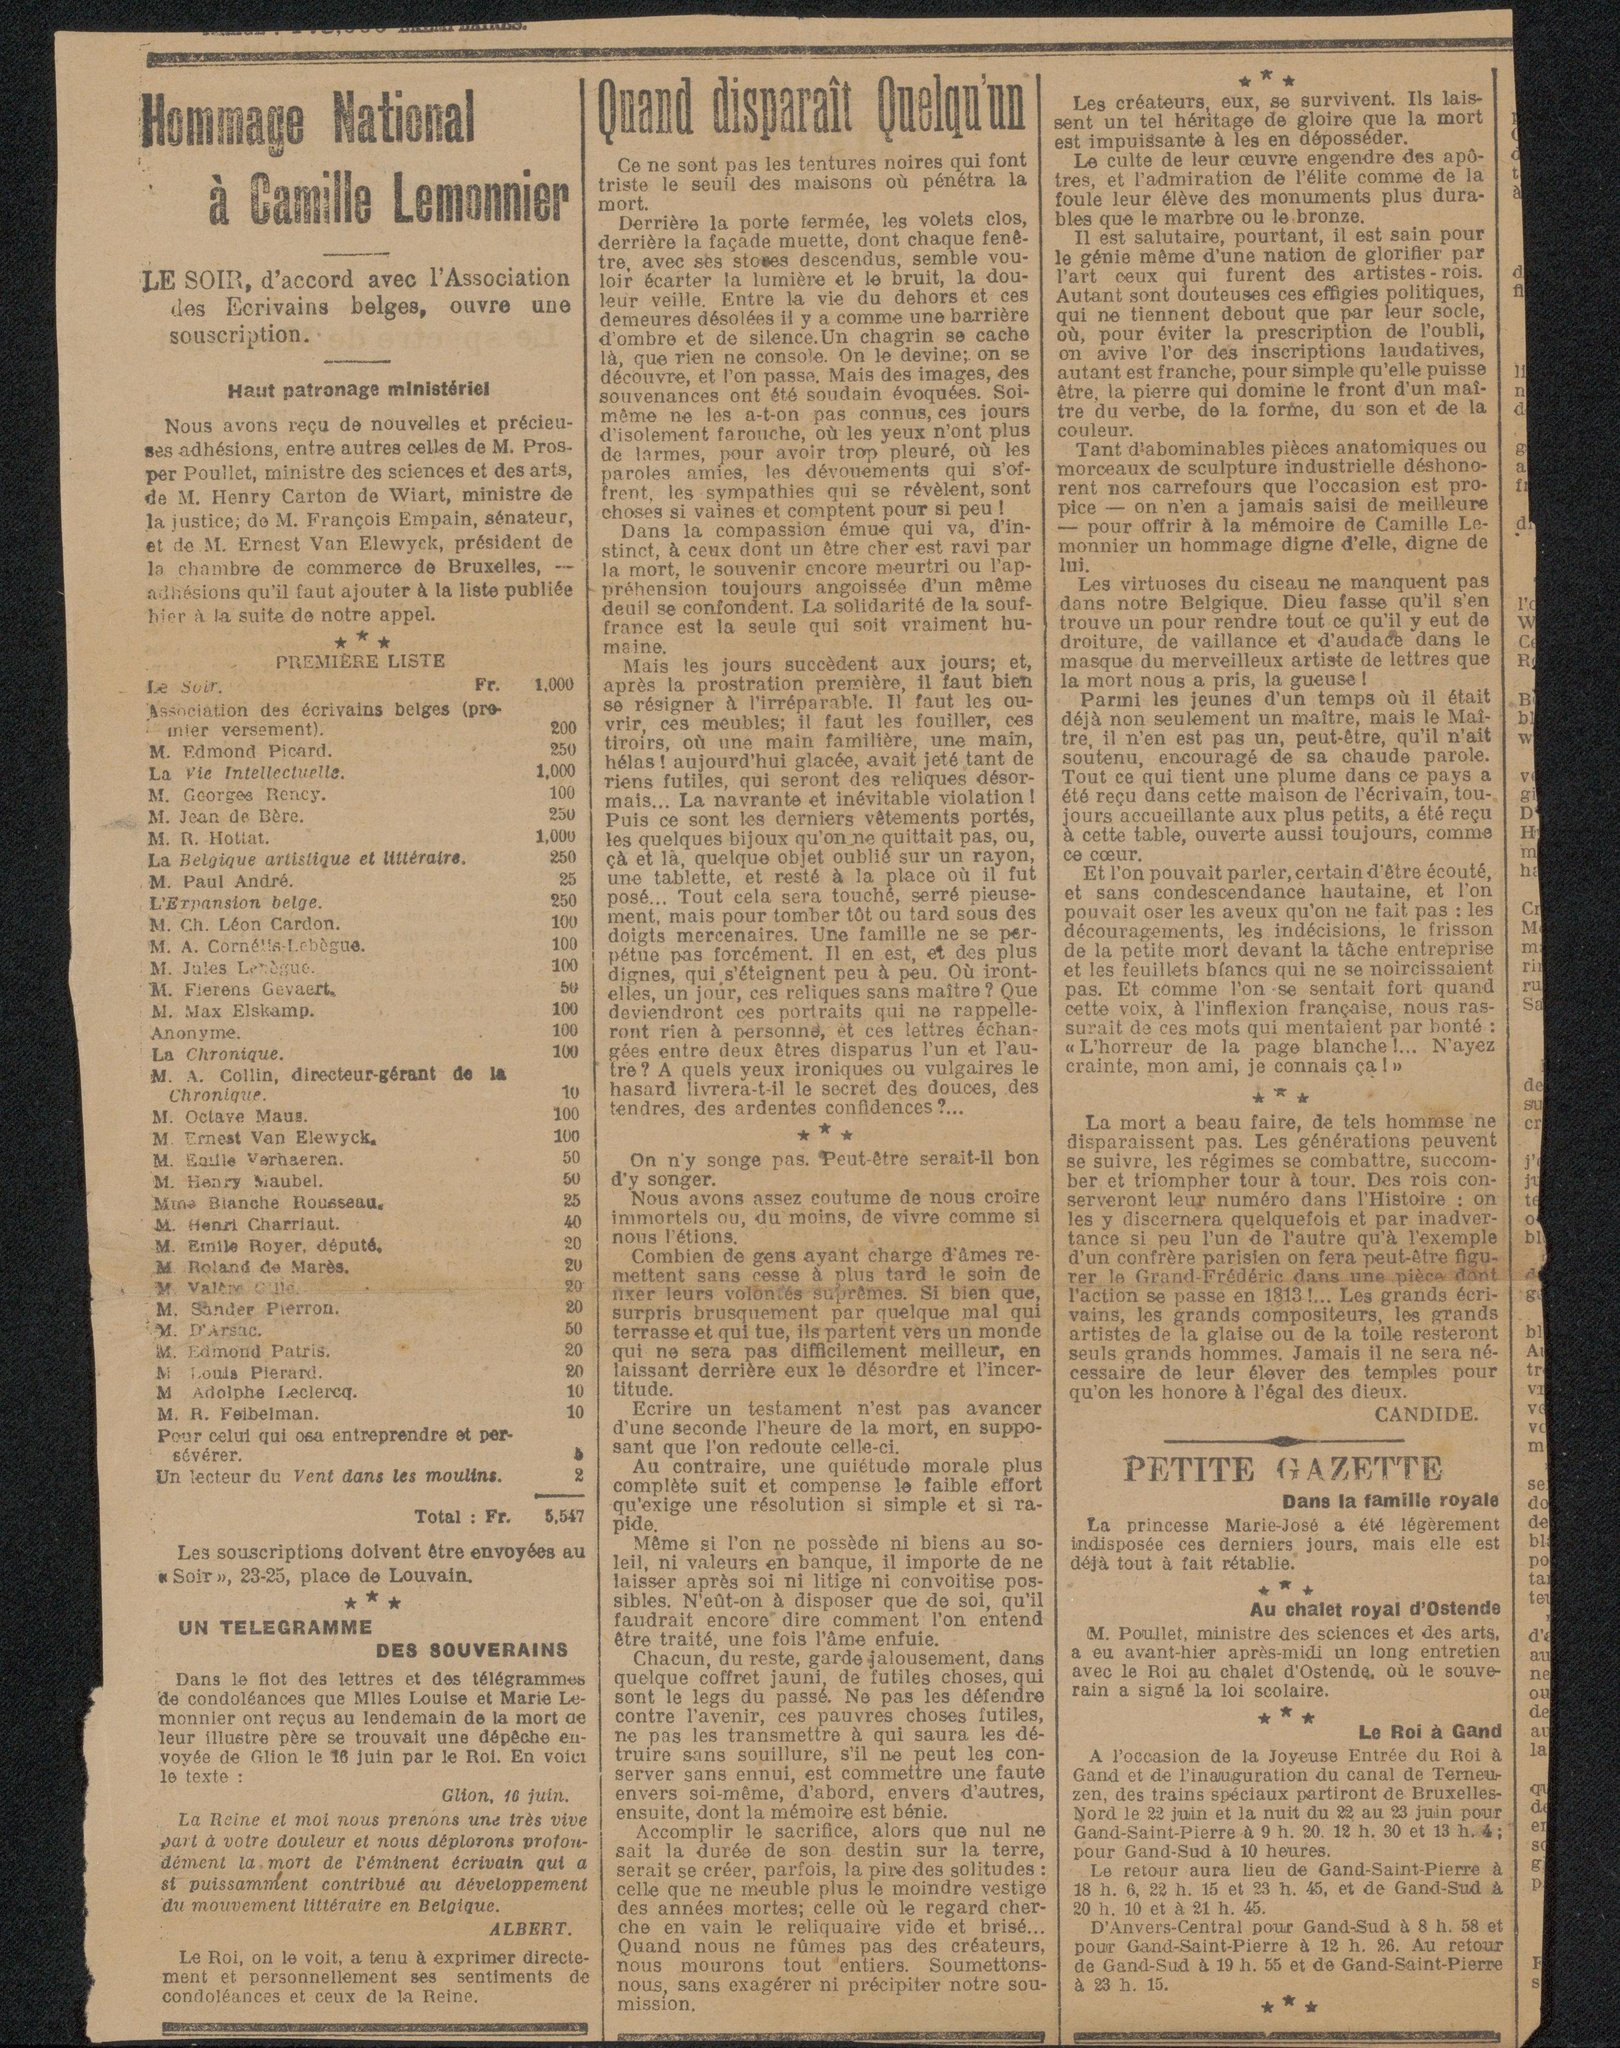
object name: newspaper clipping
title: Krantenknipsels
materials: paper, ink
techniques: printing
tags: camille lemonnier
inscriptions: collector's mark: ‘RPK’